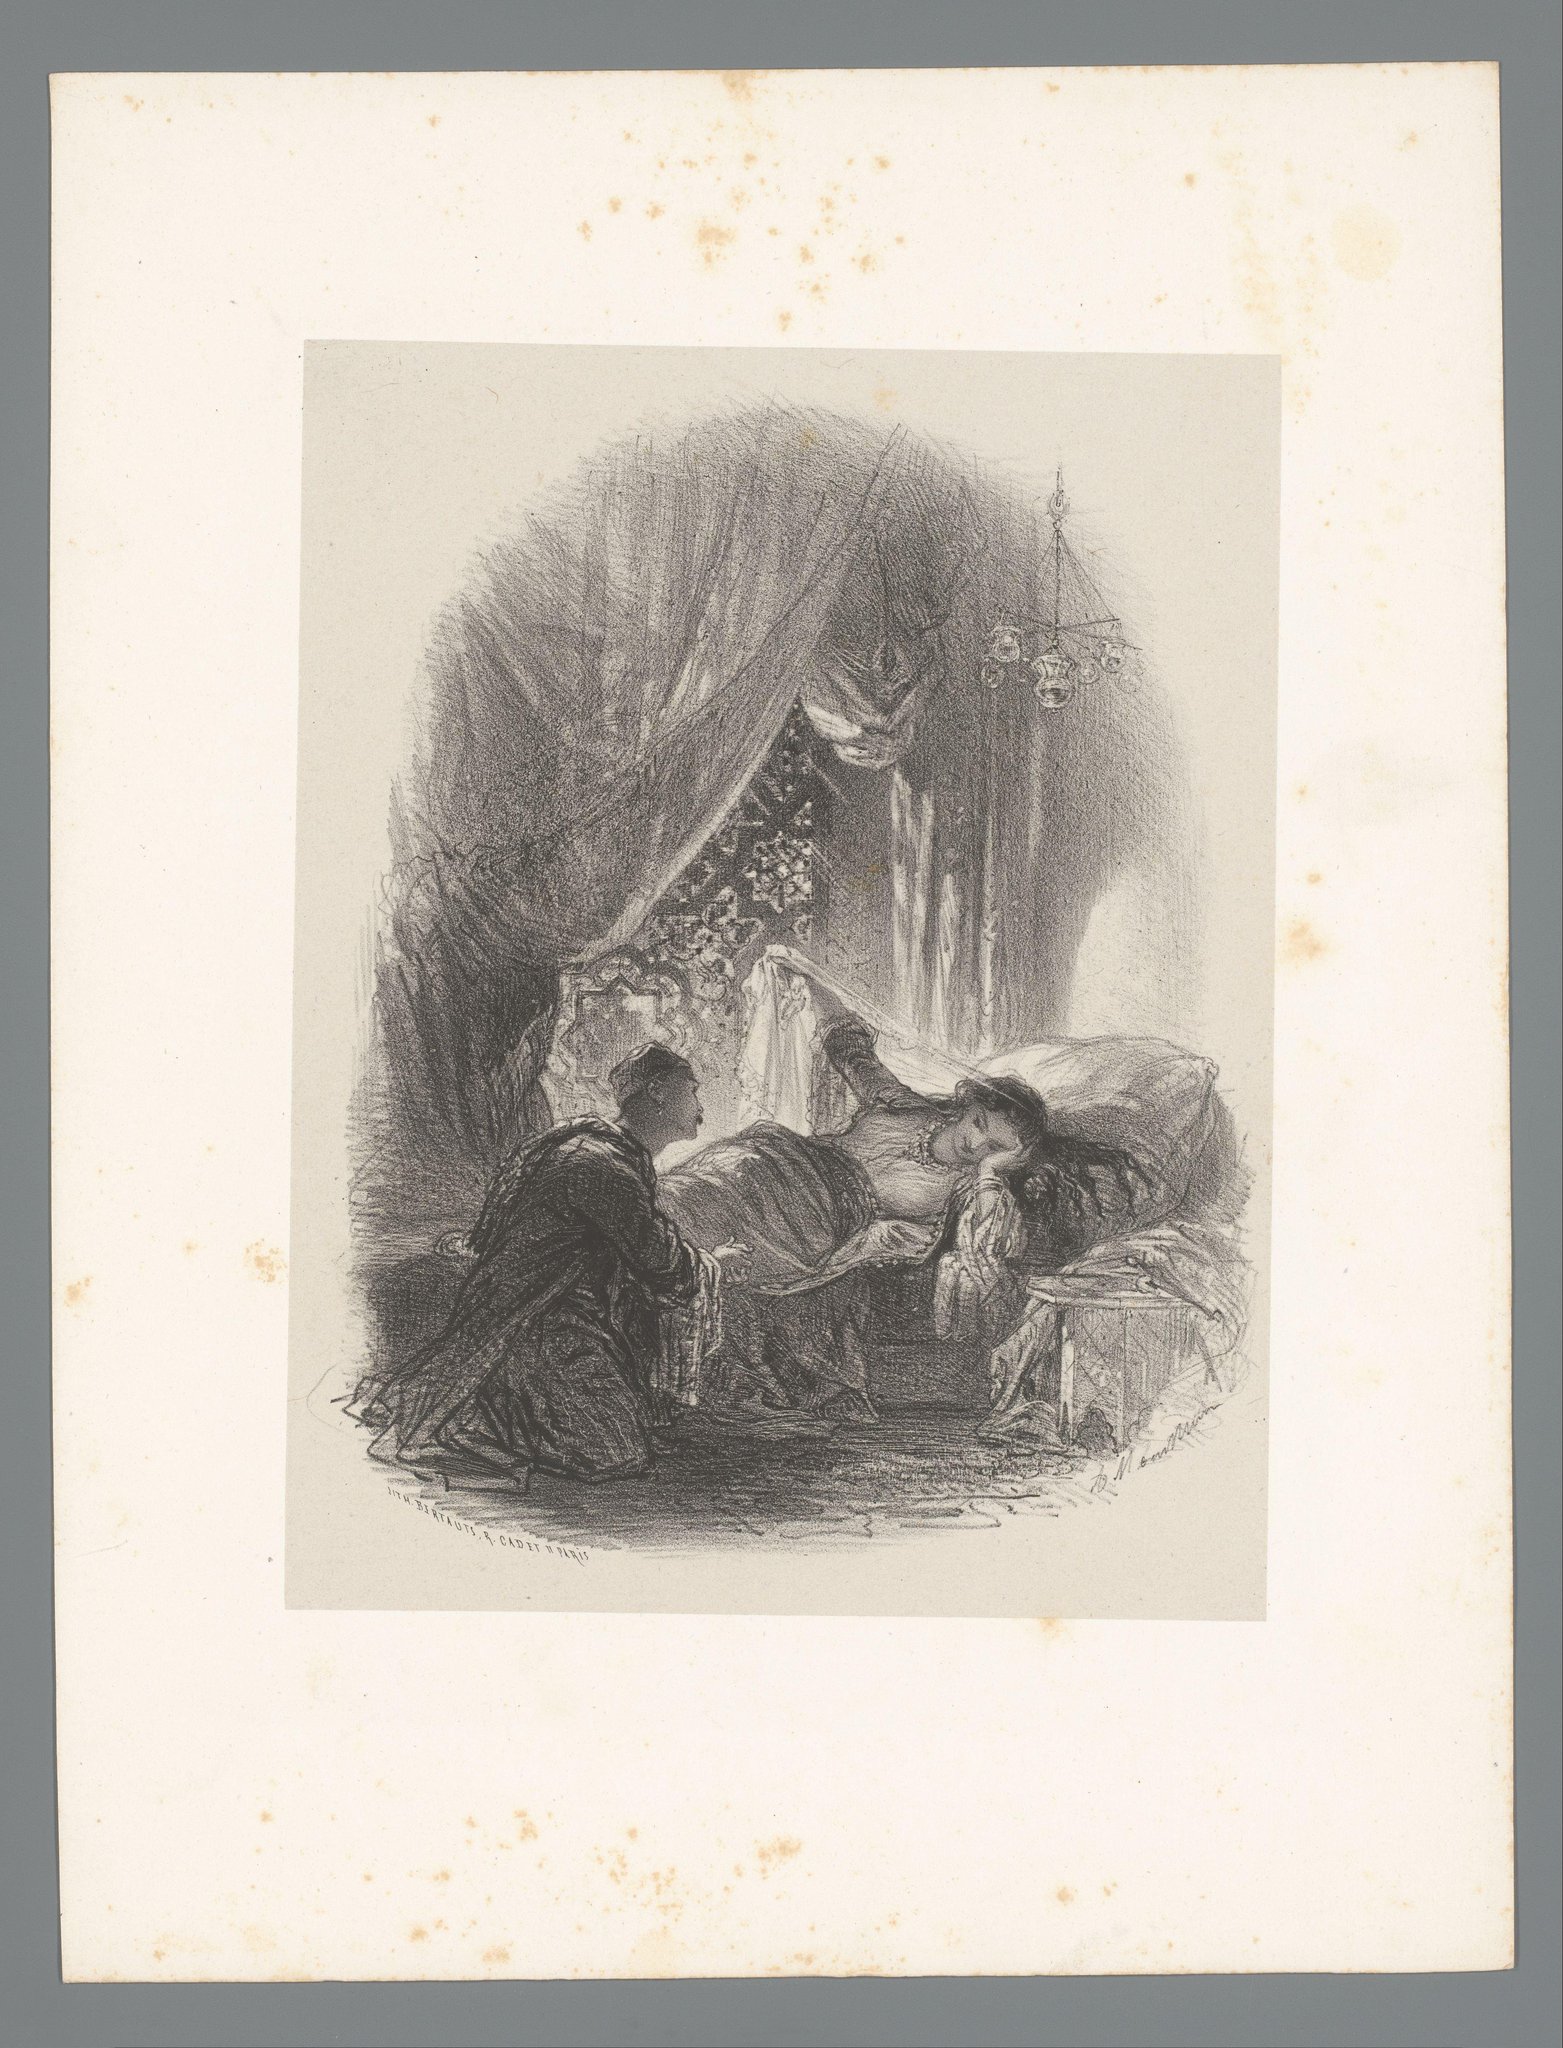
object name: print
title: Man knielt voor een vrouw op ligbed in een oosterse kamer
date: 1851-1865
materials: paper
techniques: lithograph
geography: paris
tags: adult man, kneeling figure, lying figure - aa - female human figure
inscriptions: collector's mark: Lugt 964